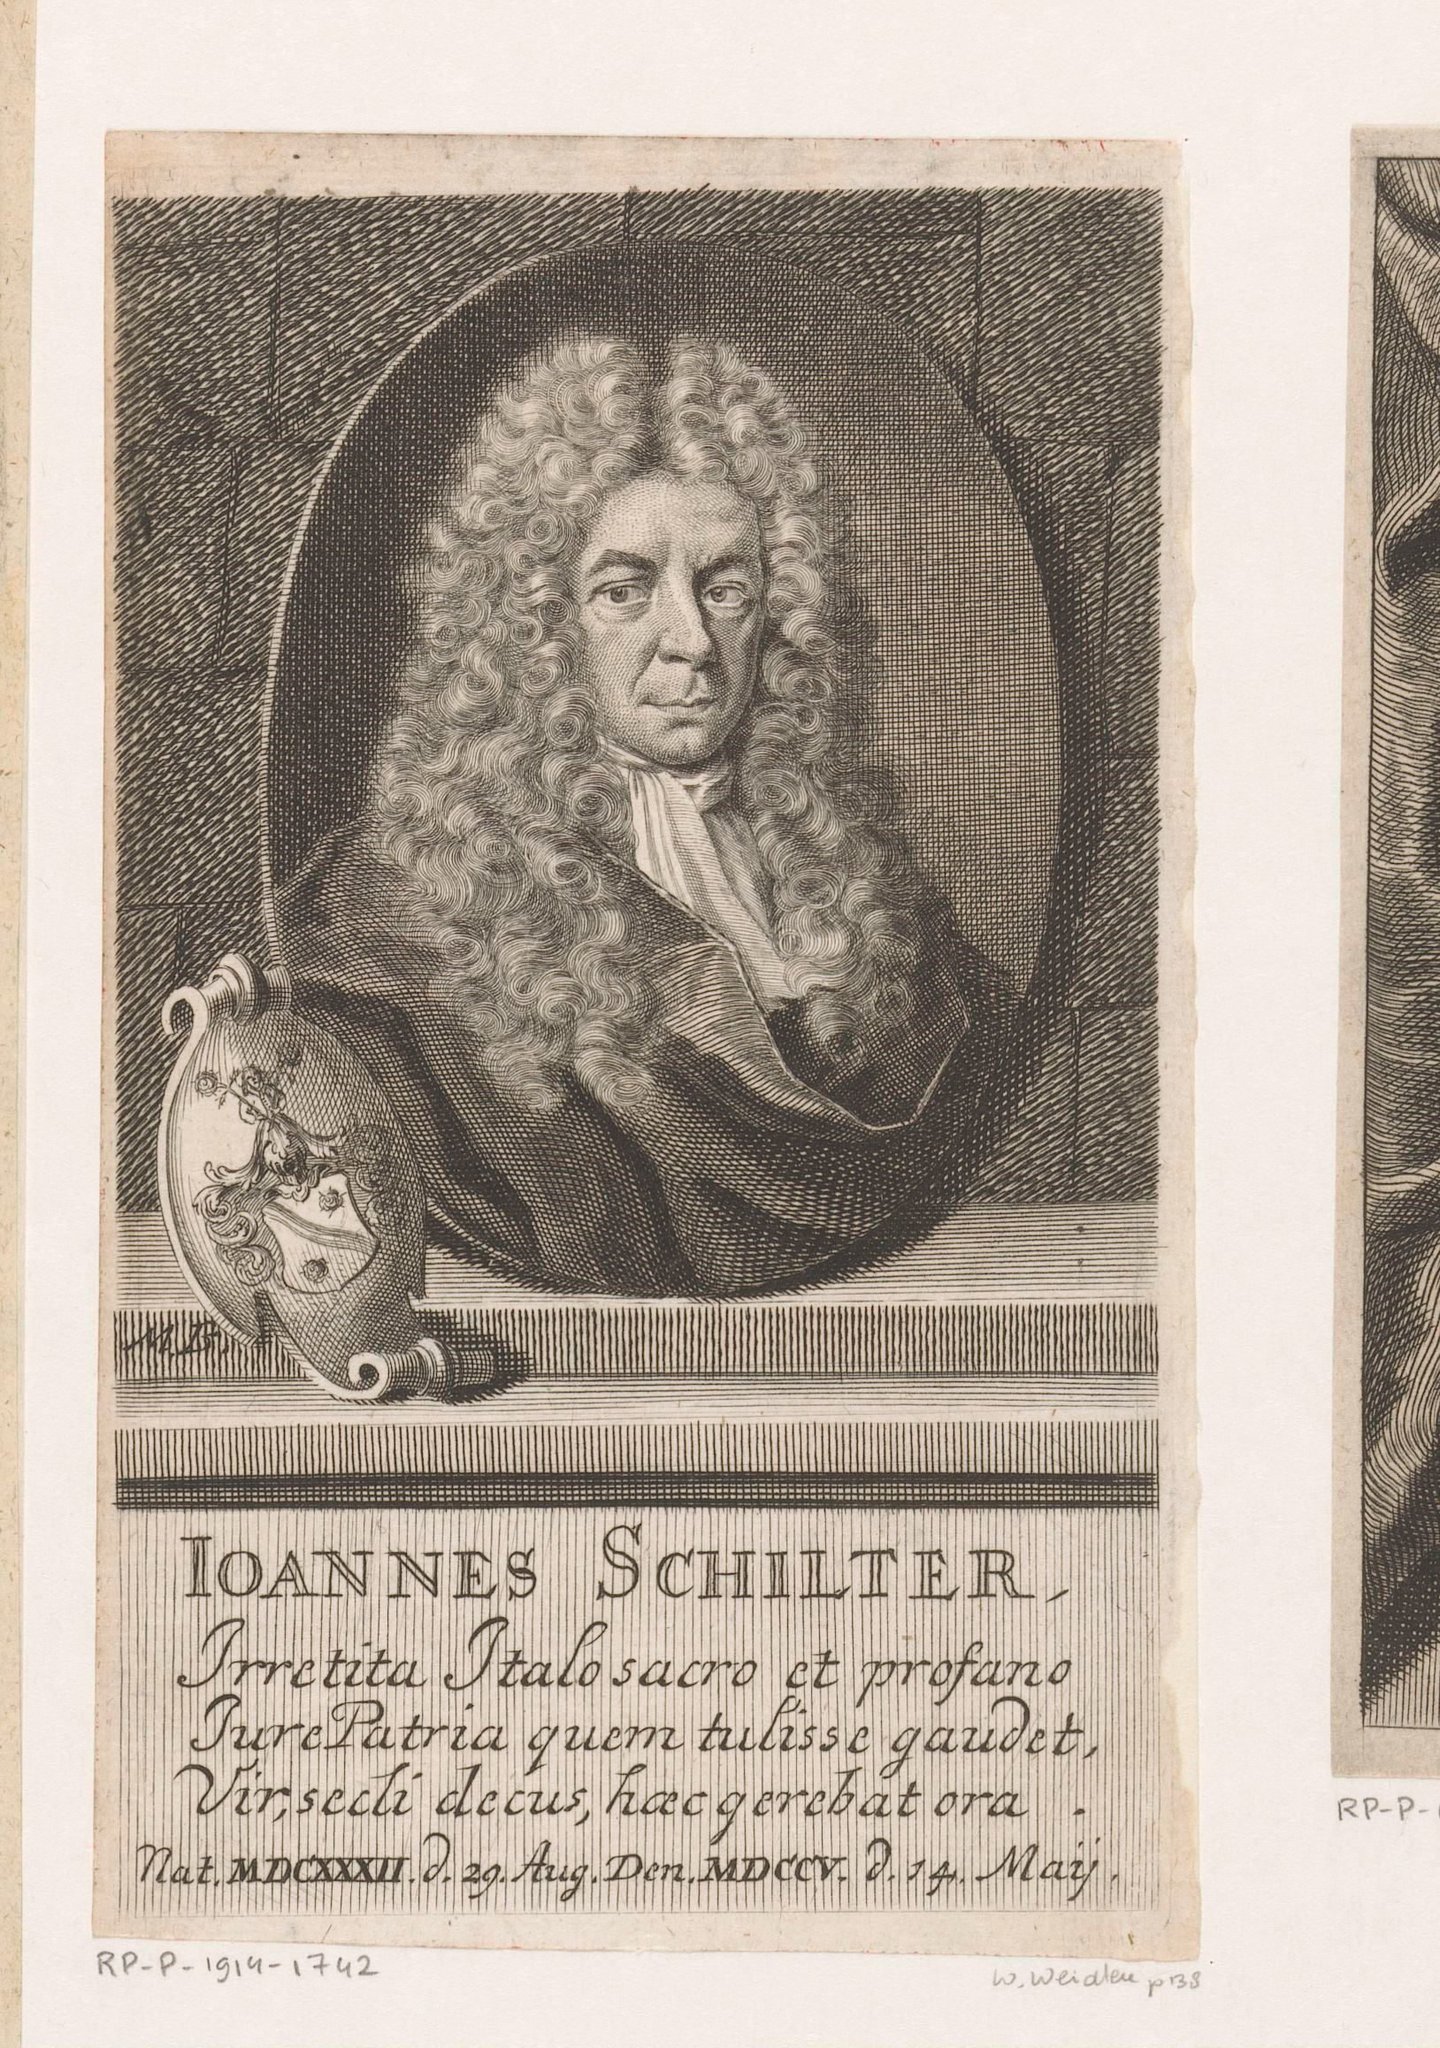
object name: print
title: Portret van Johann Schilter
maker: martin bernigeroth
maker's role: print maker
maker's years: 1670-1733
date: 1718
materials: paper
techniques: engraving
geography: leipzig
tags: historical persons, armorial bearing, heraldry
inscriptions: collector's mark: Lugt 2228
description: Prent ook gebruikt in: Schilter, Johann. Institutiones Juris Canonici ad Ecclesiae veteris et hodiernae statum accommodatae. Frankfurt am Main en Leipzig: erven Matthäus Birckner, 1718.